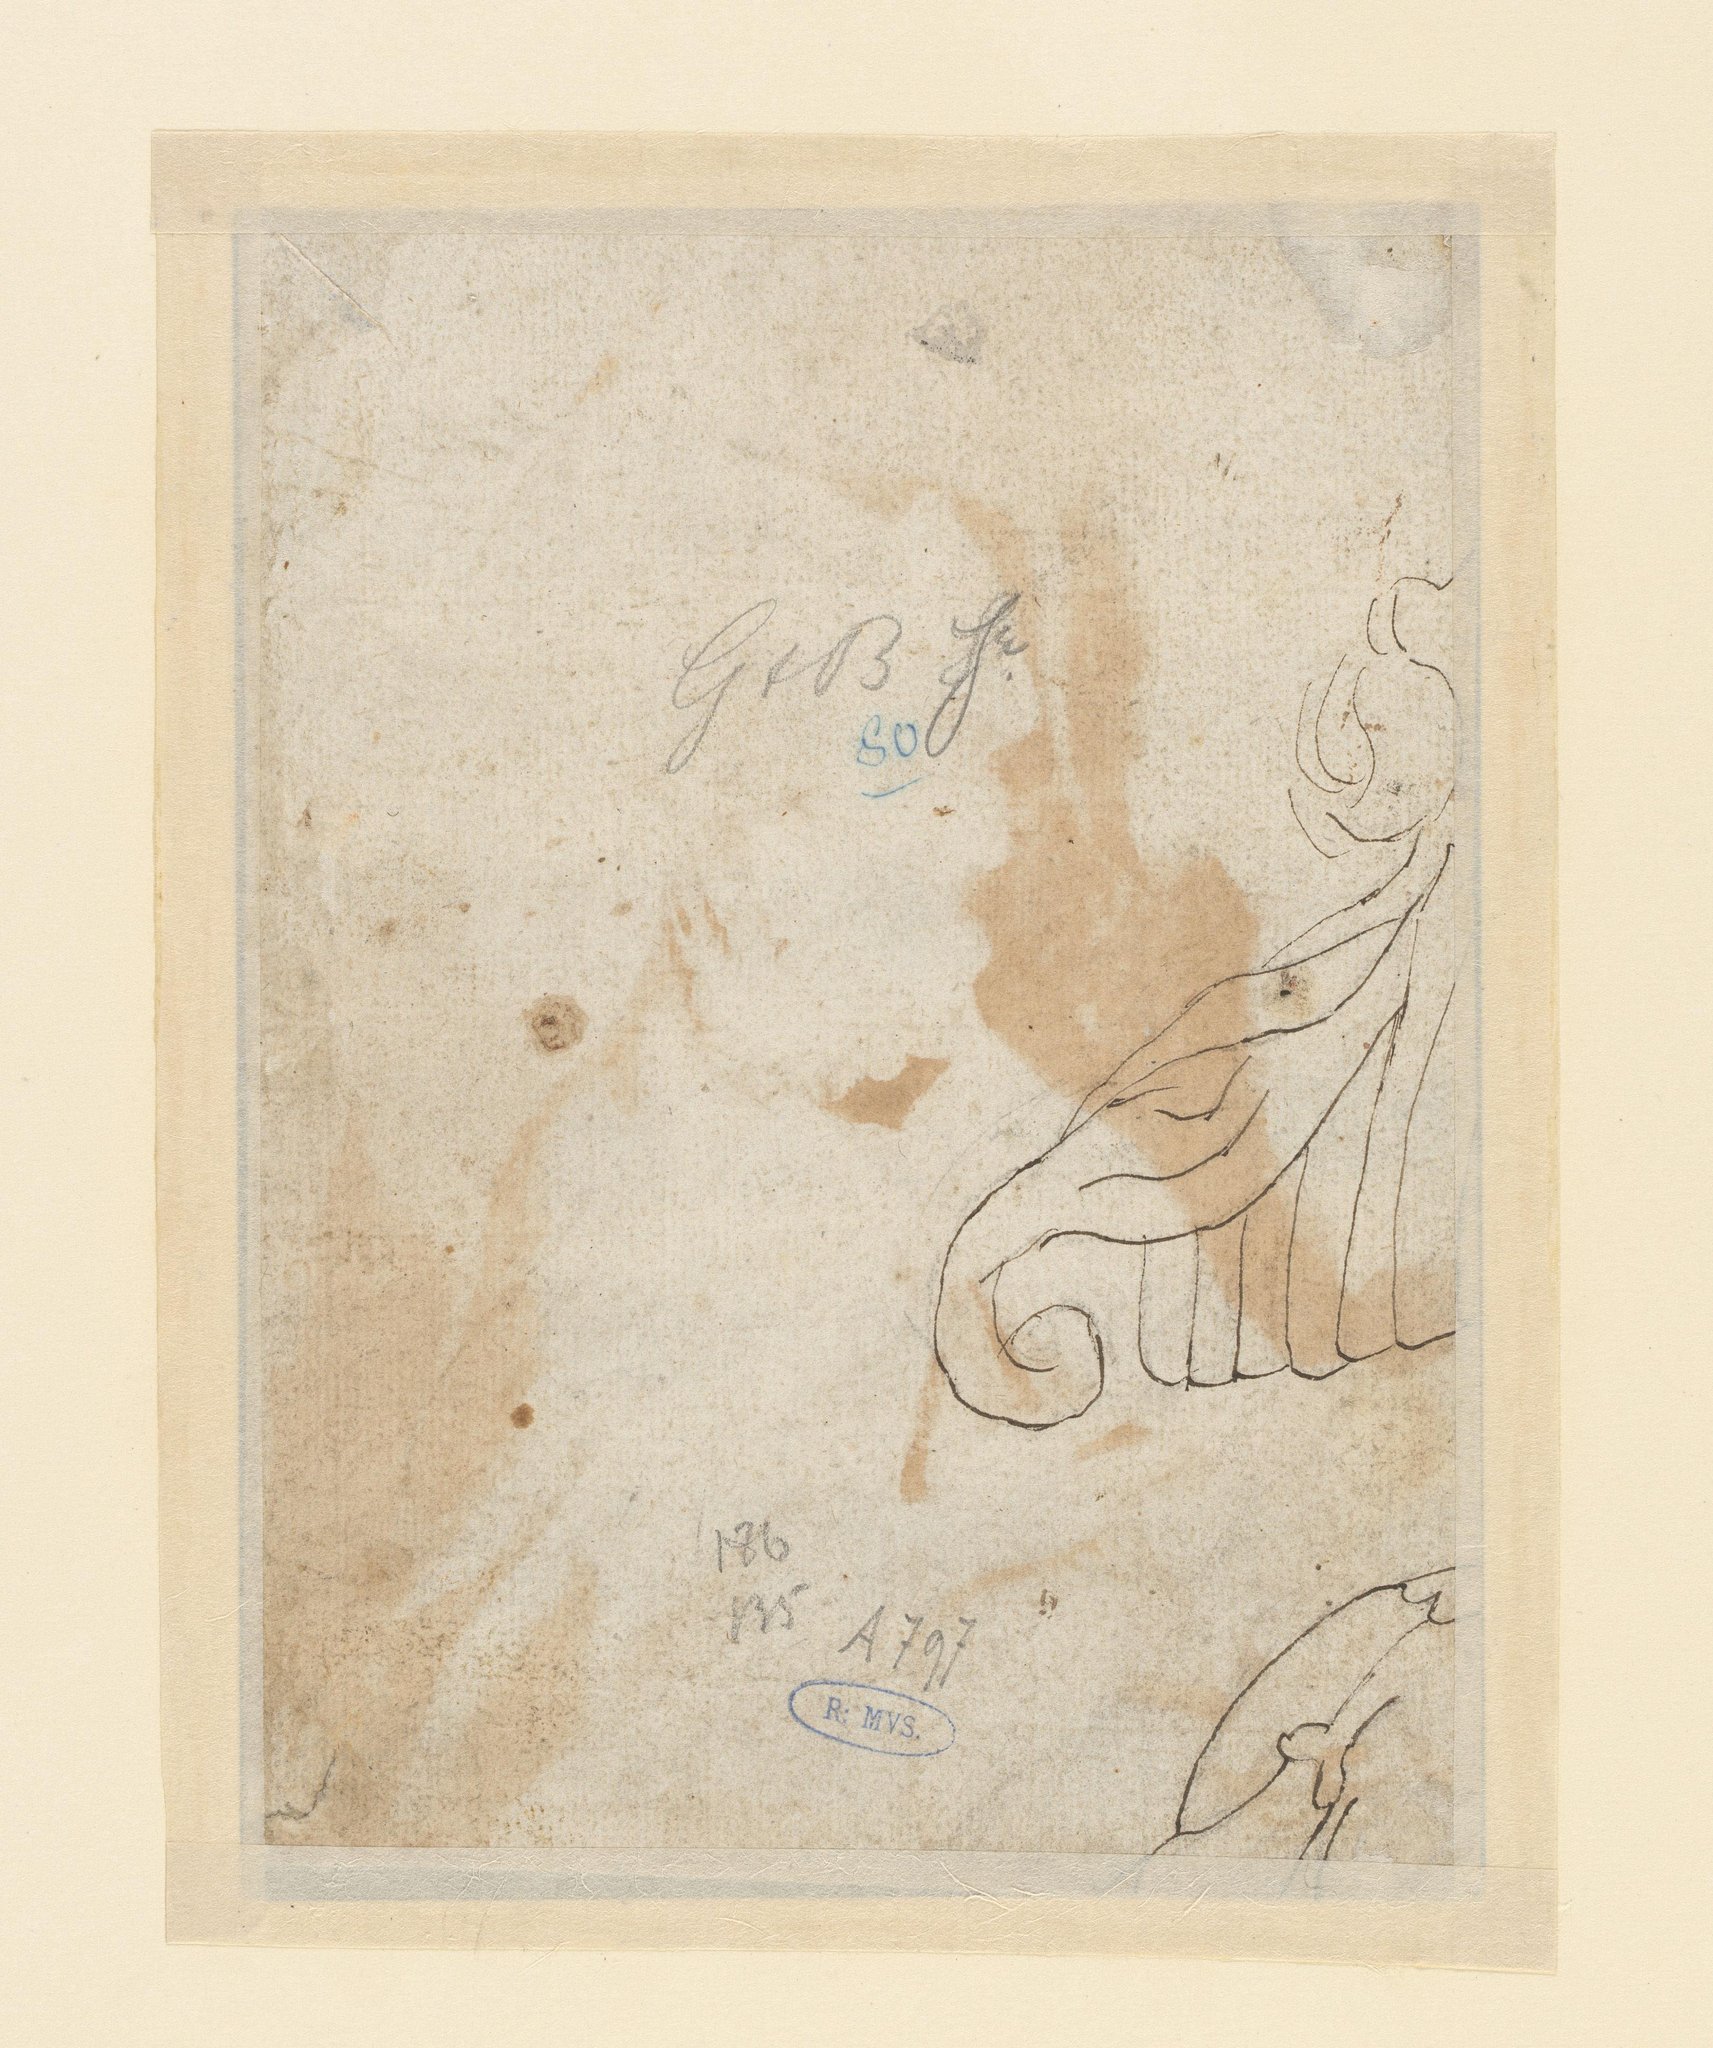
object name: drawing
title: Fragment van een rechts afgesneden tekening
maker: gerard ter borch (i)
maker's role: draughtsman, print maker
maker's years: 1584-1662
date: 1616-1624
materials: chalk, ink, paper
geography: zwolle